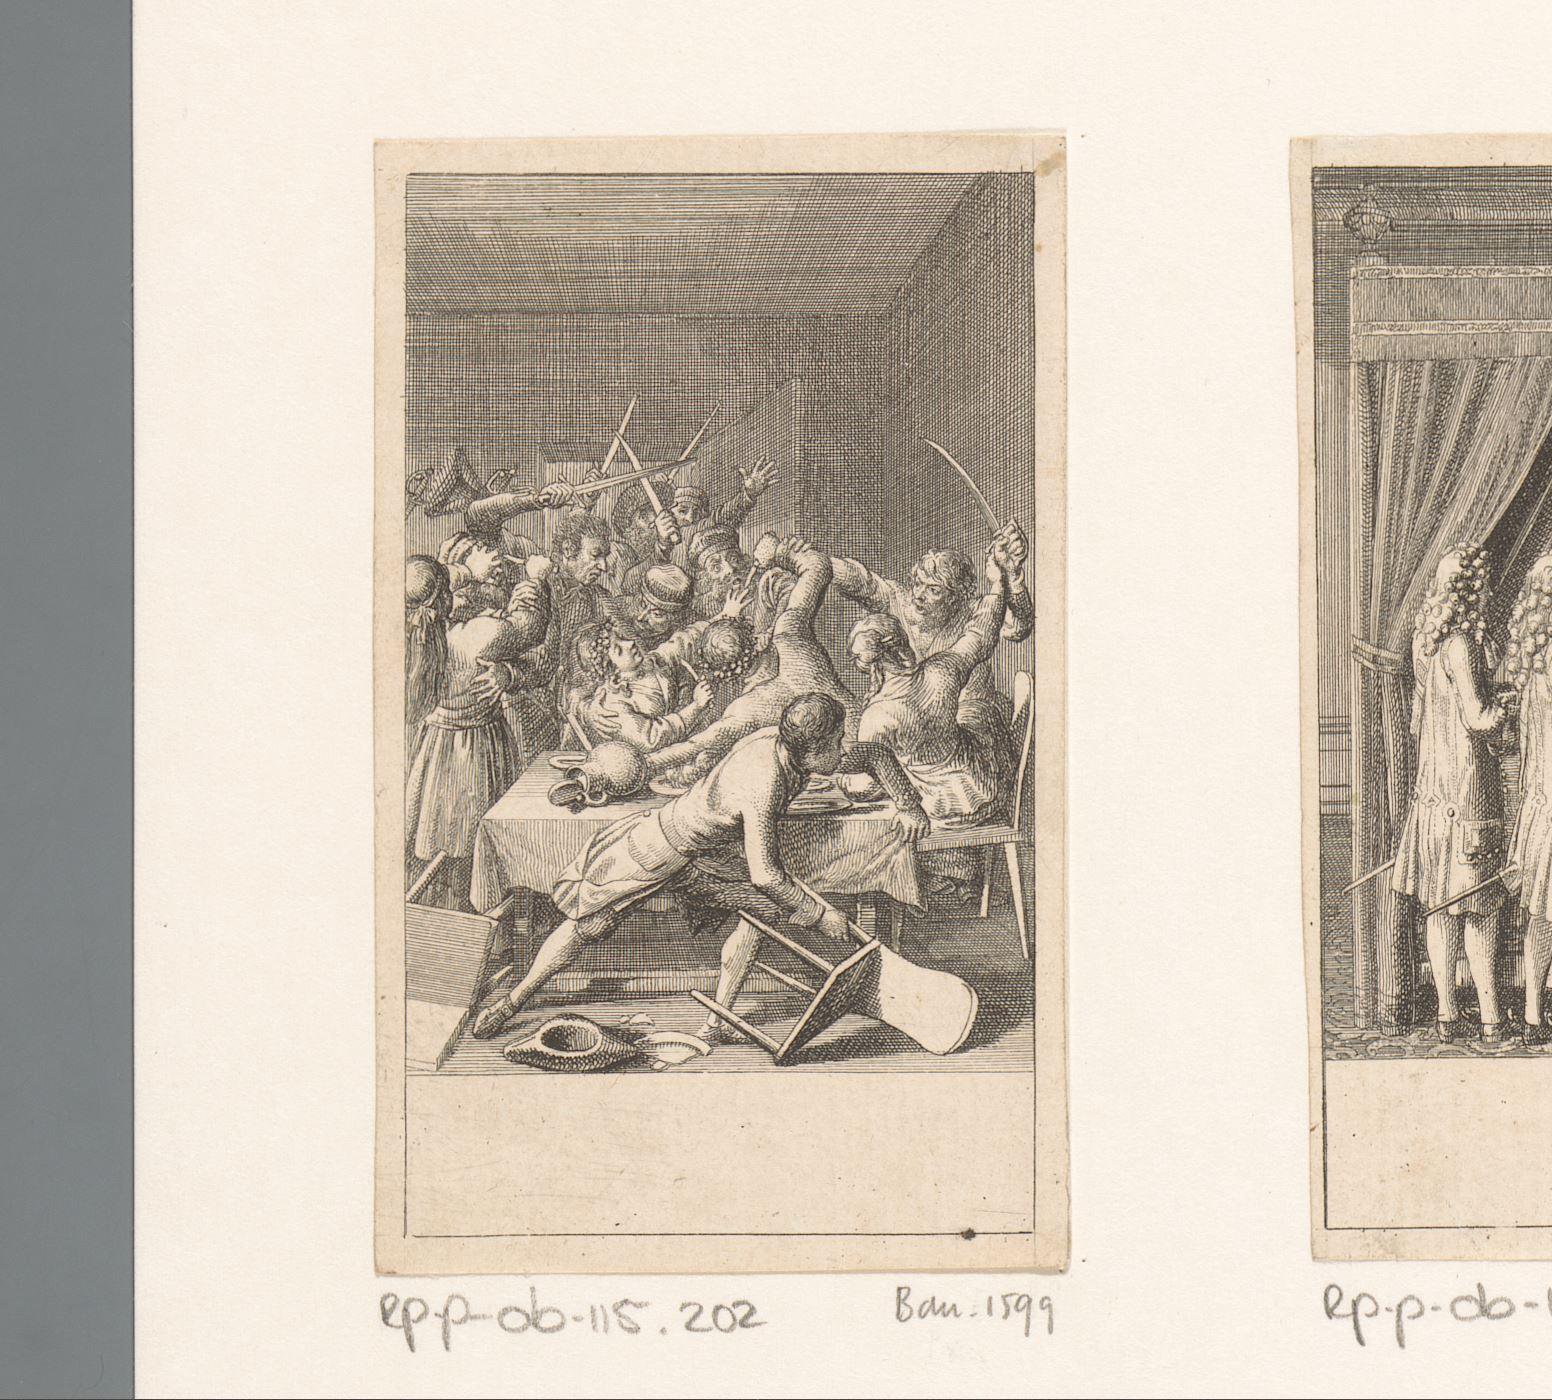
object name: print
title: Catharina Wasilowna wordt tijdens haar bruiloft overvallen door de Russen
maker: daniel nikolaus chodowiecki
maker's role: draughtsman, print maker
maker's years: 1726-1801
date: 1792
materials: paper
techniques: etching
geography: berlin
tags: catharina de grote, history, bride (in wedding-dress), war, betrothal and marriage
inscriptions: collector's mark: Lugt 2228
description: Latere staat gebruikt voor: Almanac de Gotha pour l'anneé 1793. Gotha: C. W. Ettinger, [1792].